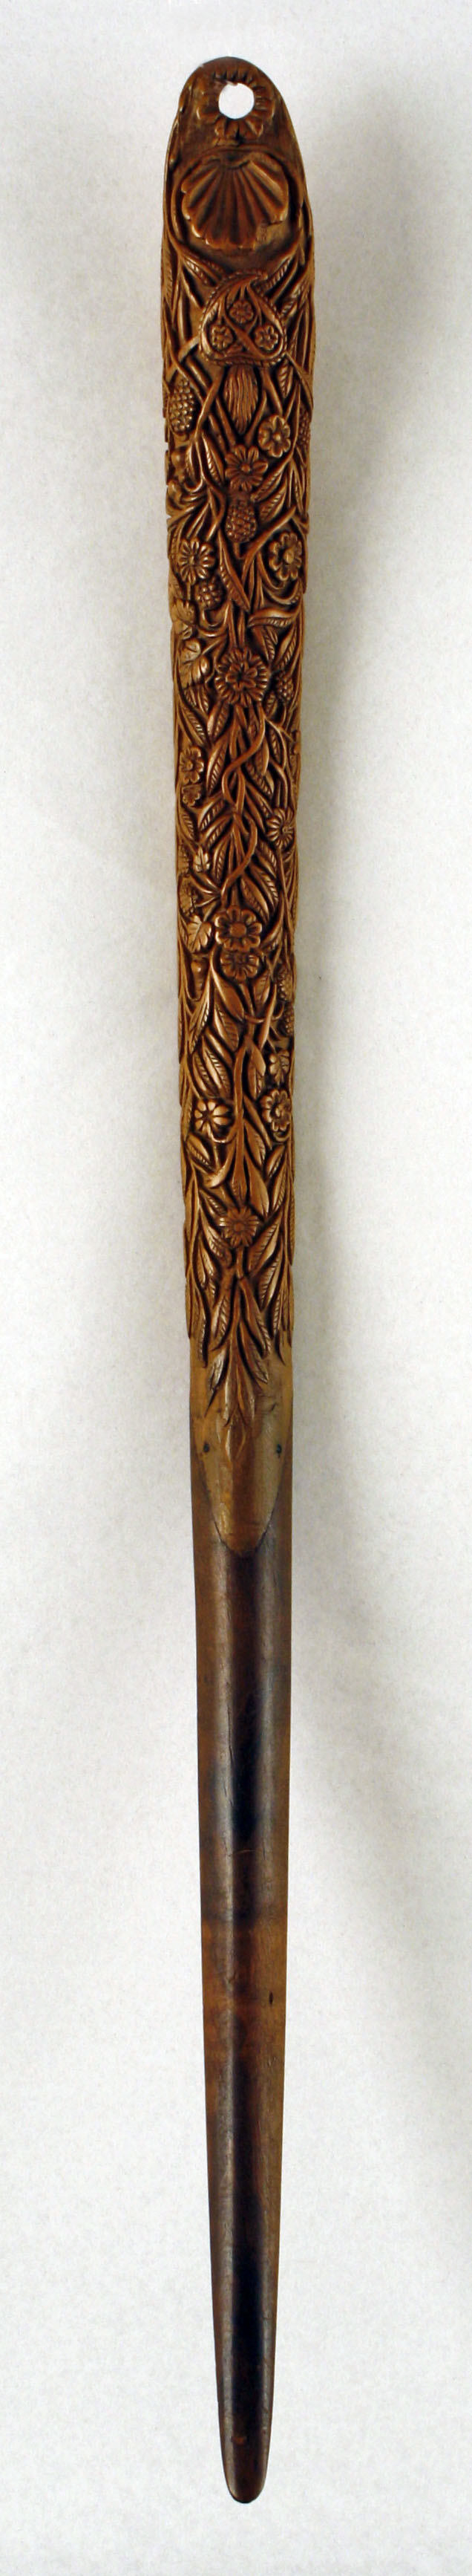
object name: busk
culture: italian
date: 1600-1825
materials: wood